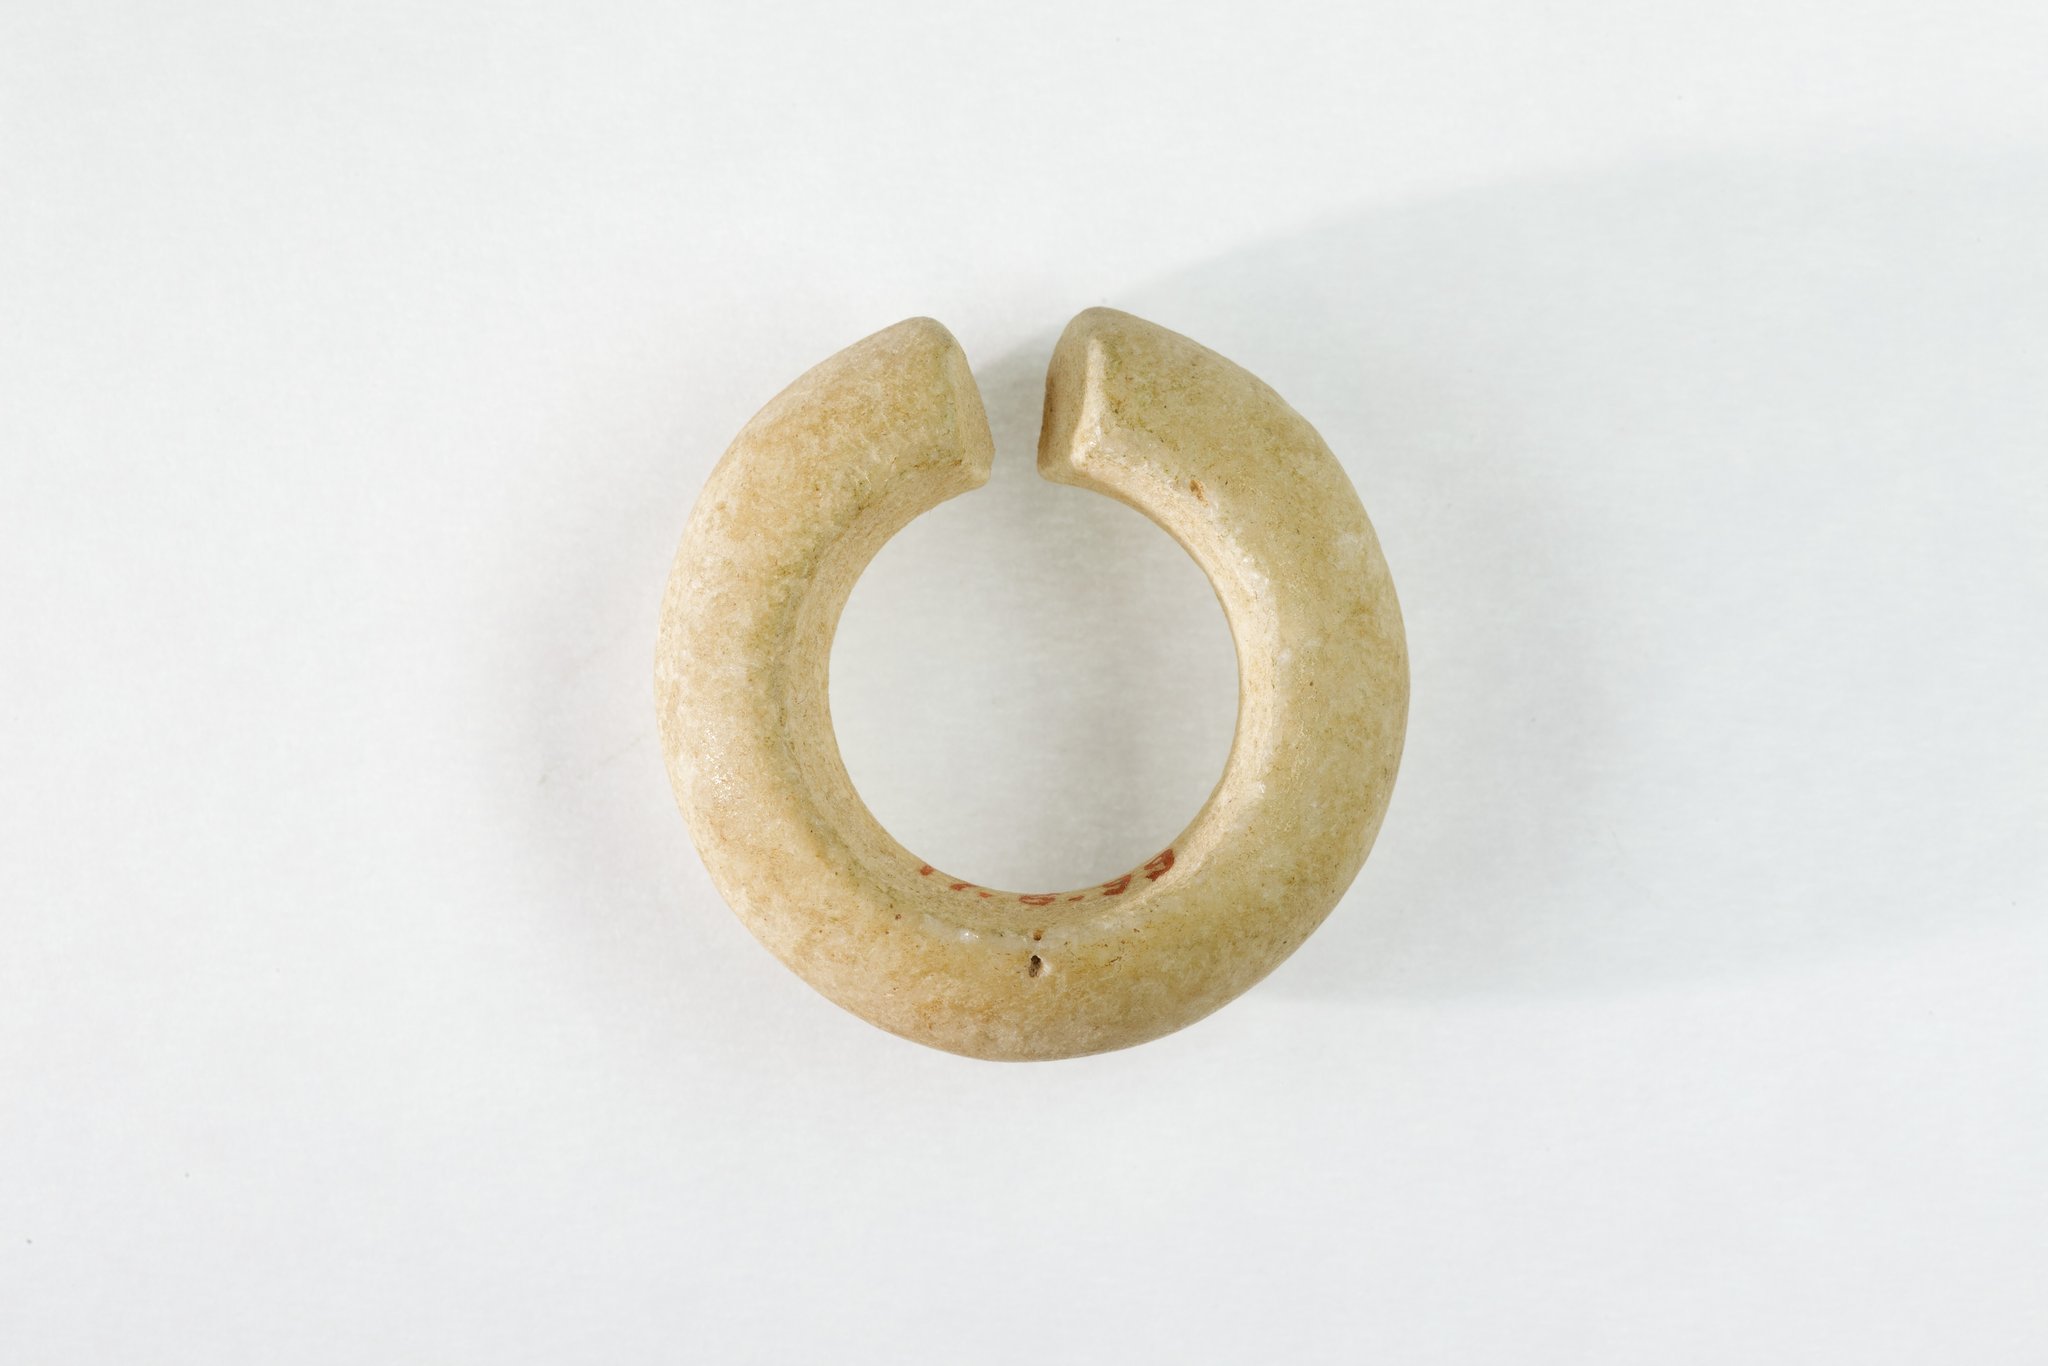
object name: earring, penannular, circular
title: Penannular Earring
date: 1550-1295 BCE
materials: shell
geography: northern upper egypt